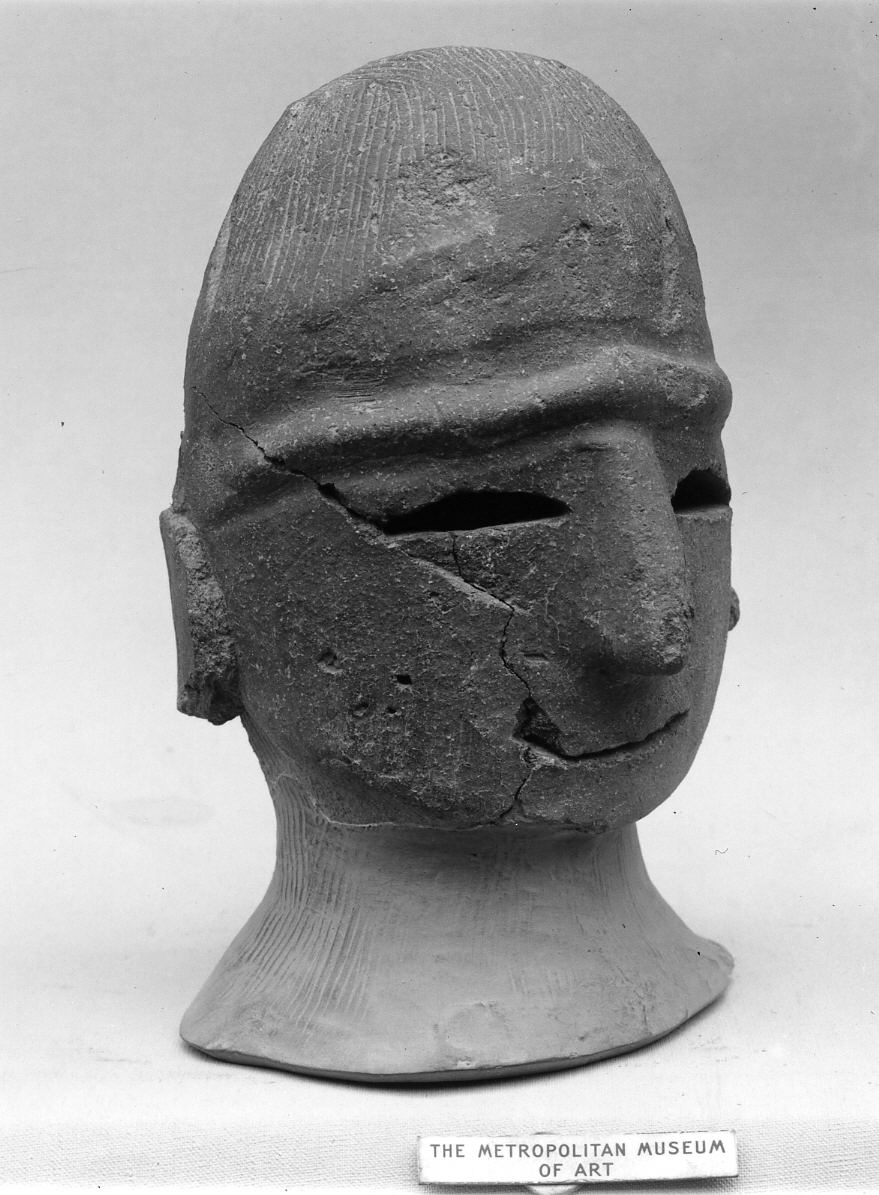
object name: haniwa head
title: Head of a Male Haniwa Figure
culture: japanese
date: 201-700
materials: earthenware